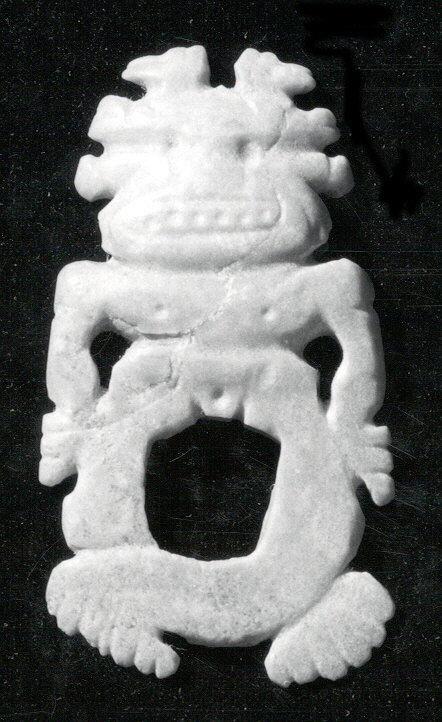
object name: pendant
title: Figure Pendant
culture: atlantic watershed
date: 301-800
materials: jade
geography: costa rica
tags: human figures